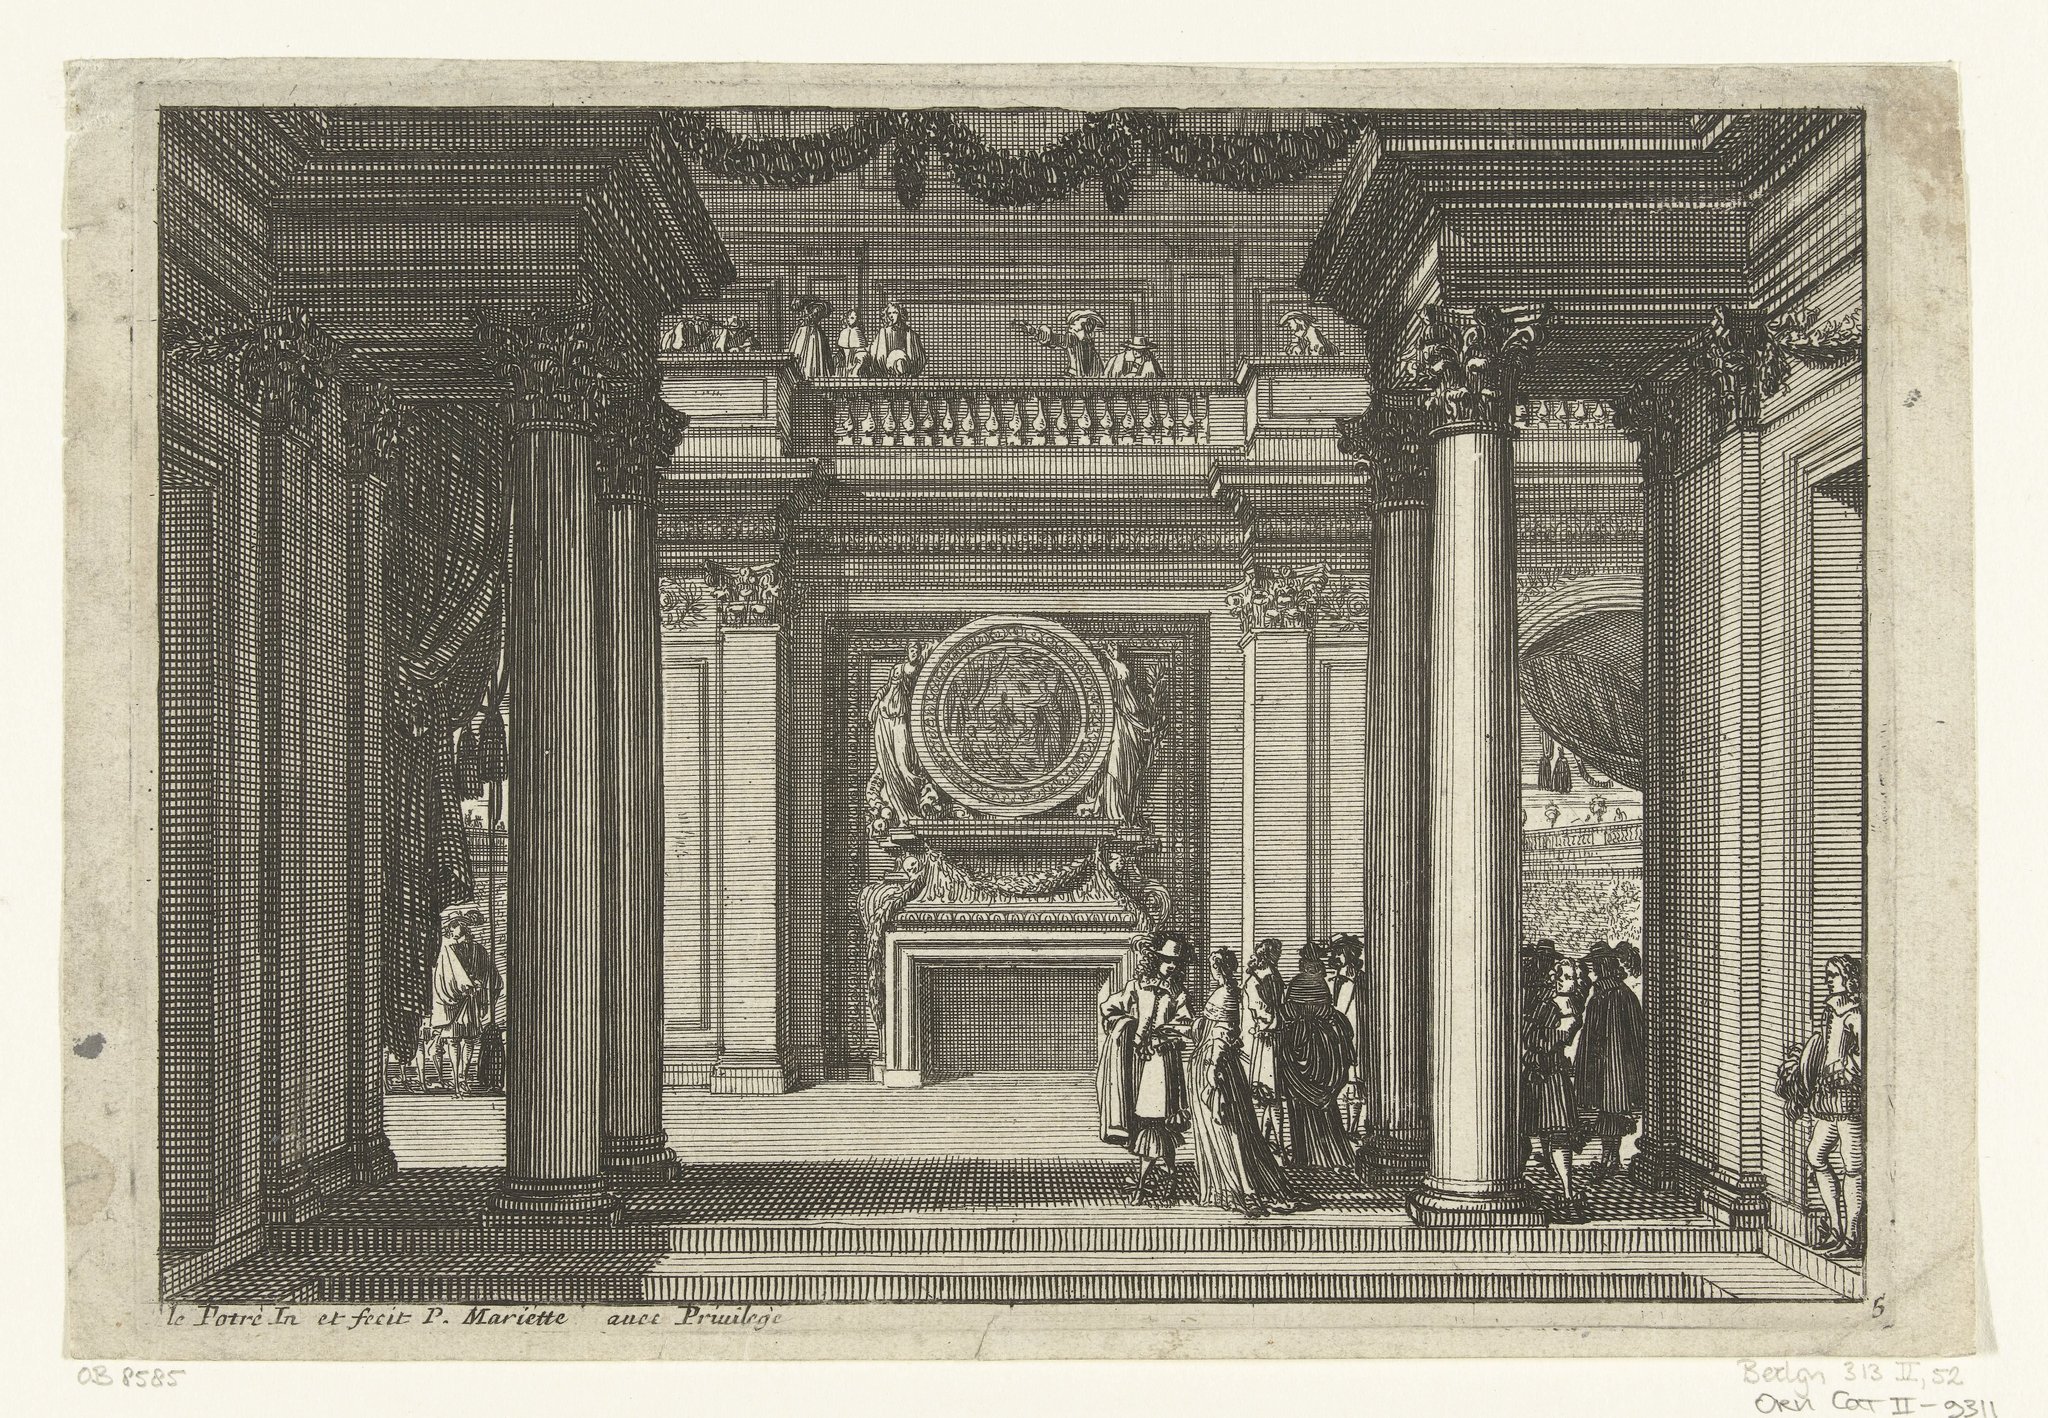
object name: print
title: Cheminées et Lambris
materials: paper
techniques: etching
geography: paris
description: Een schouw met rond medaillon tegen de muur van een voorkamer met daarboven een balustrade. Rechts vooraan staat een groep mensen bij twee zuilen. Uit tweede editie van serie bladen met onderboezems en houten lambrisering.